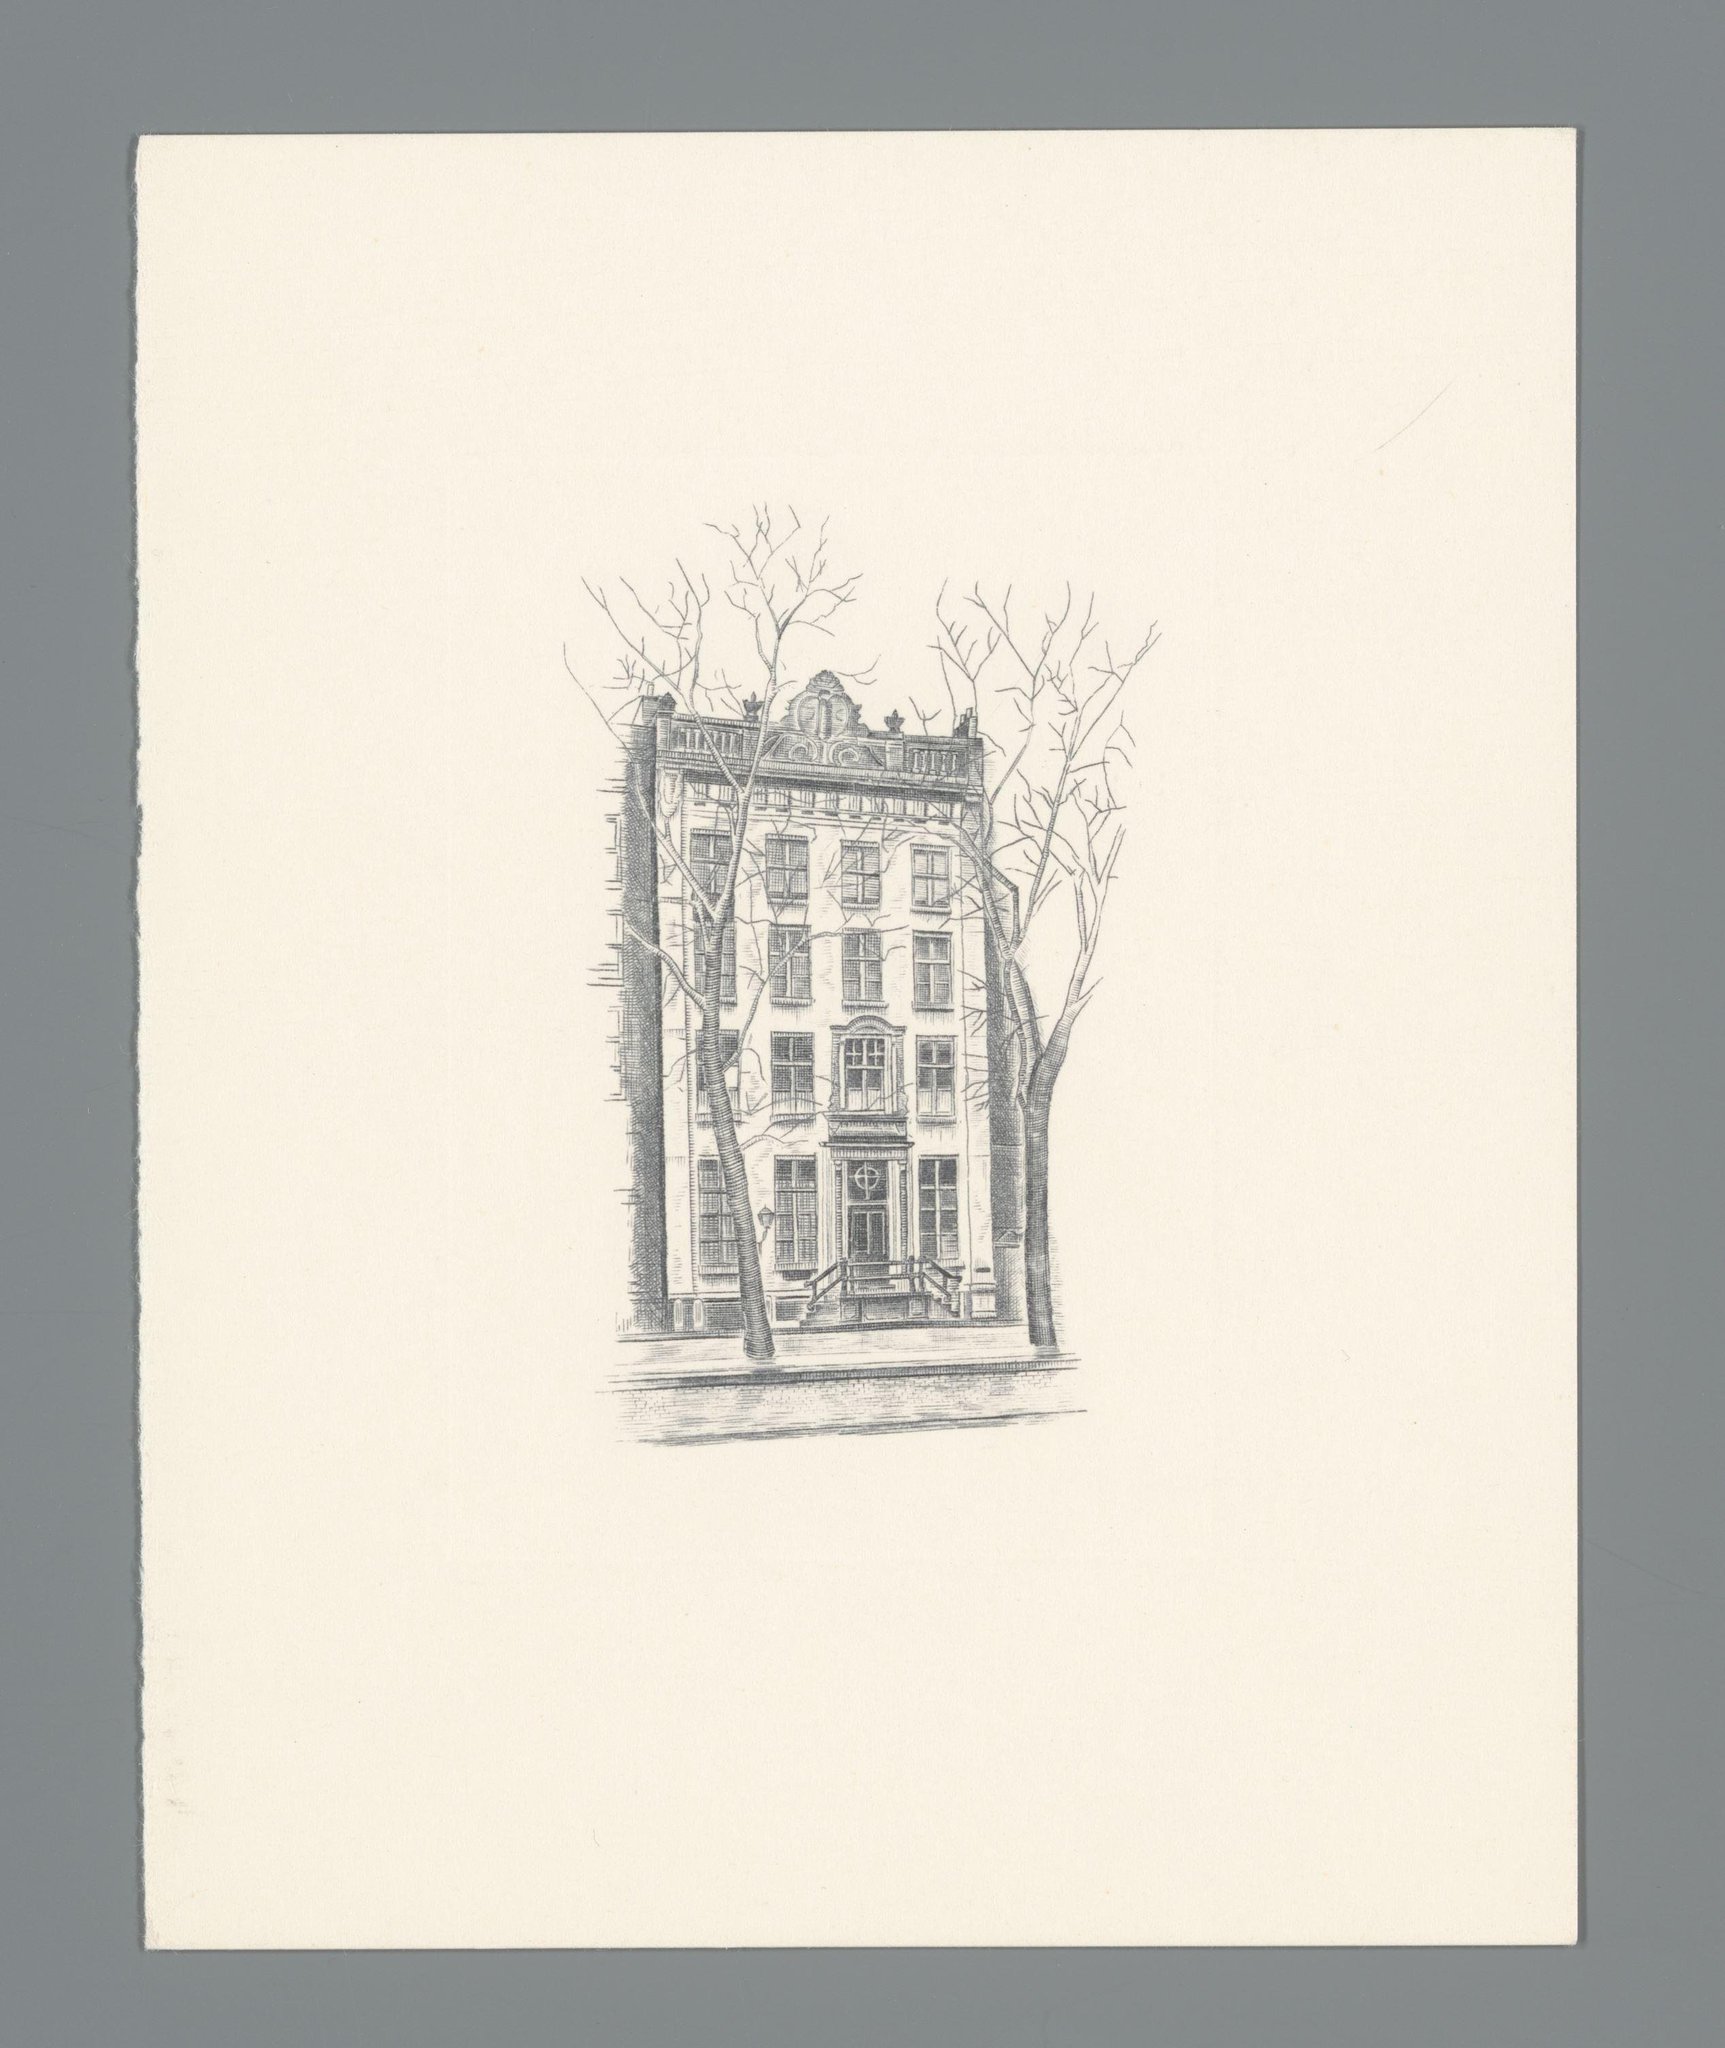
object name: print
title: Gezicht op een pand aan de Keizersgracht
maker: Anonymous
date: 1850-1950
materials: paper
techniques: etching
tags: façade (of house or building), amsterdam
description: Waarschijnlijk gaat het om Huis Saxenburg, Keizersgracht 224.